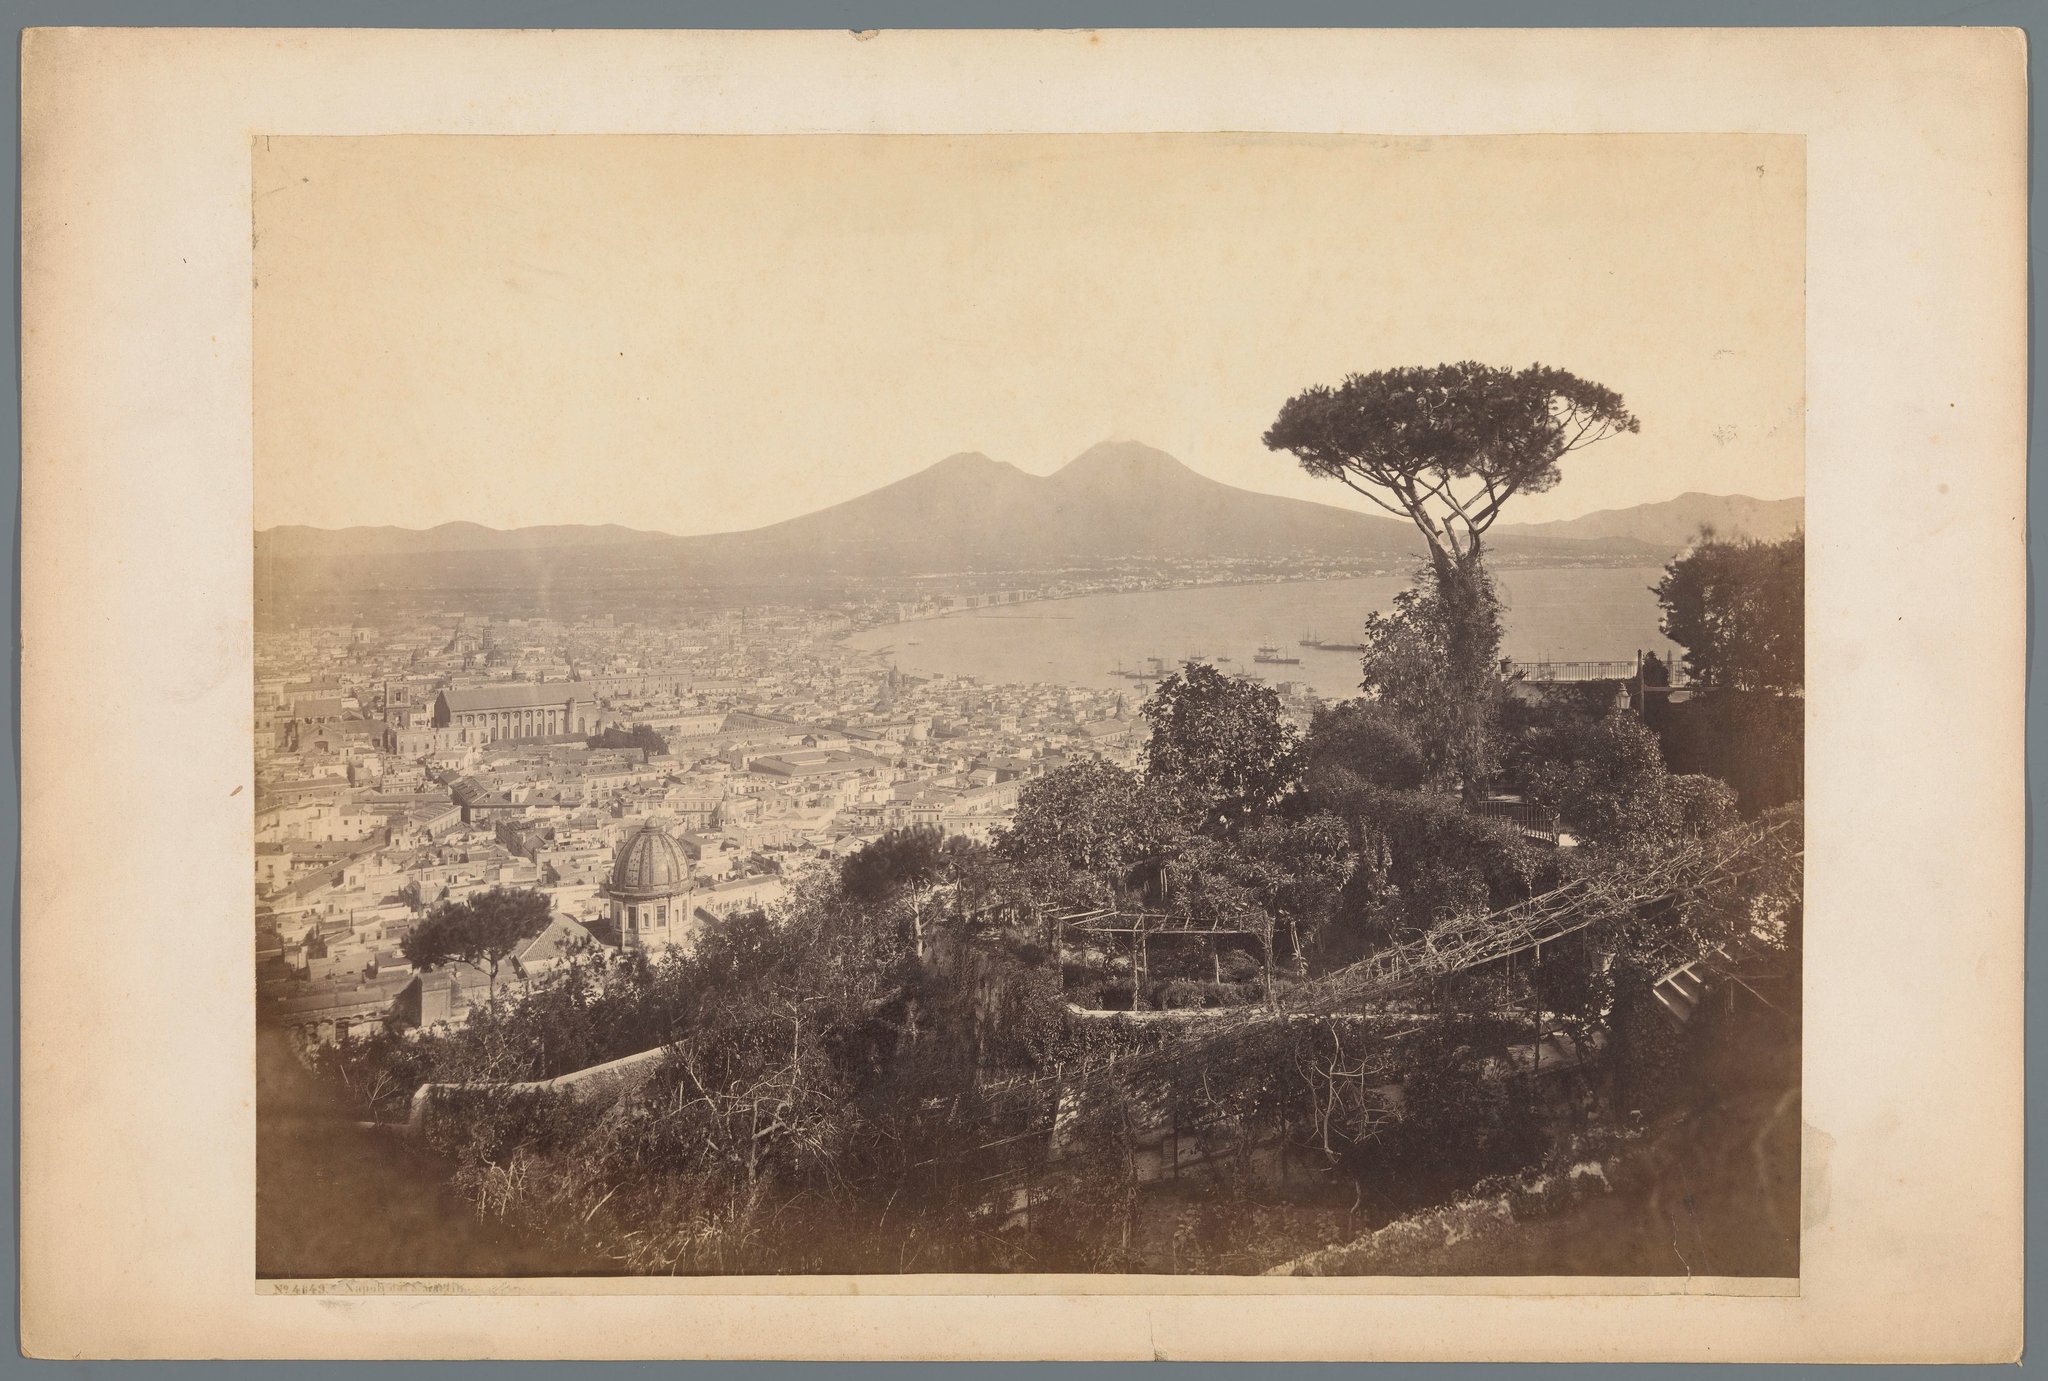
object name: photograph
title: Napoli da[(...).]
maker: Anonymous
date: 1875-1900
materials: cardboard, photographic support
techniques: albumen print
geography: naples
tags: gulf, bay - hh - ideal landscapes, prospect of city, town panorama, silhouette of city, naples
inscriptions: collector's mark: Lugt 3937, number: ‘No. 4849.’